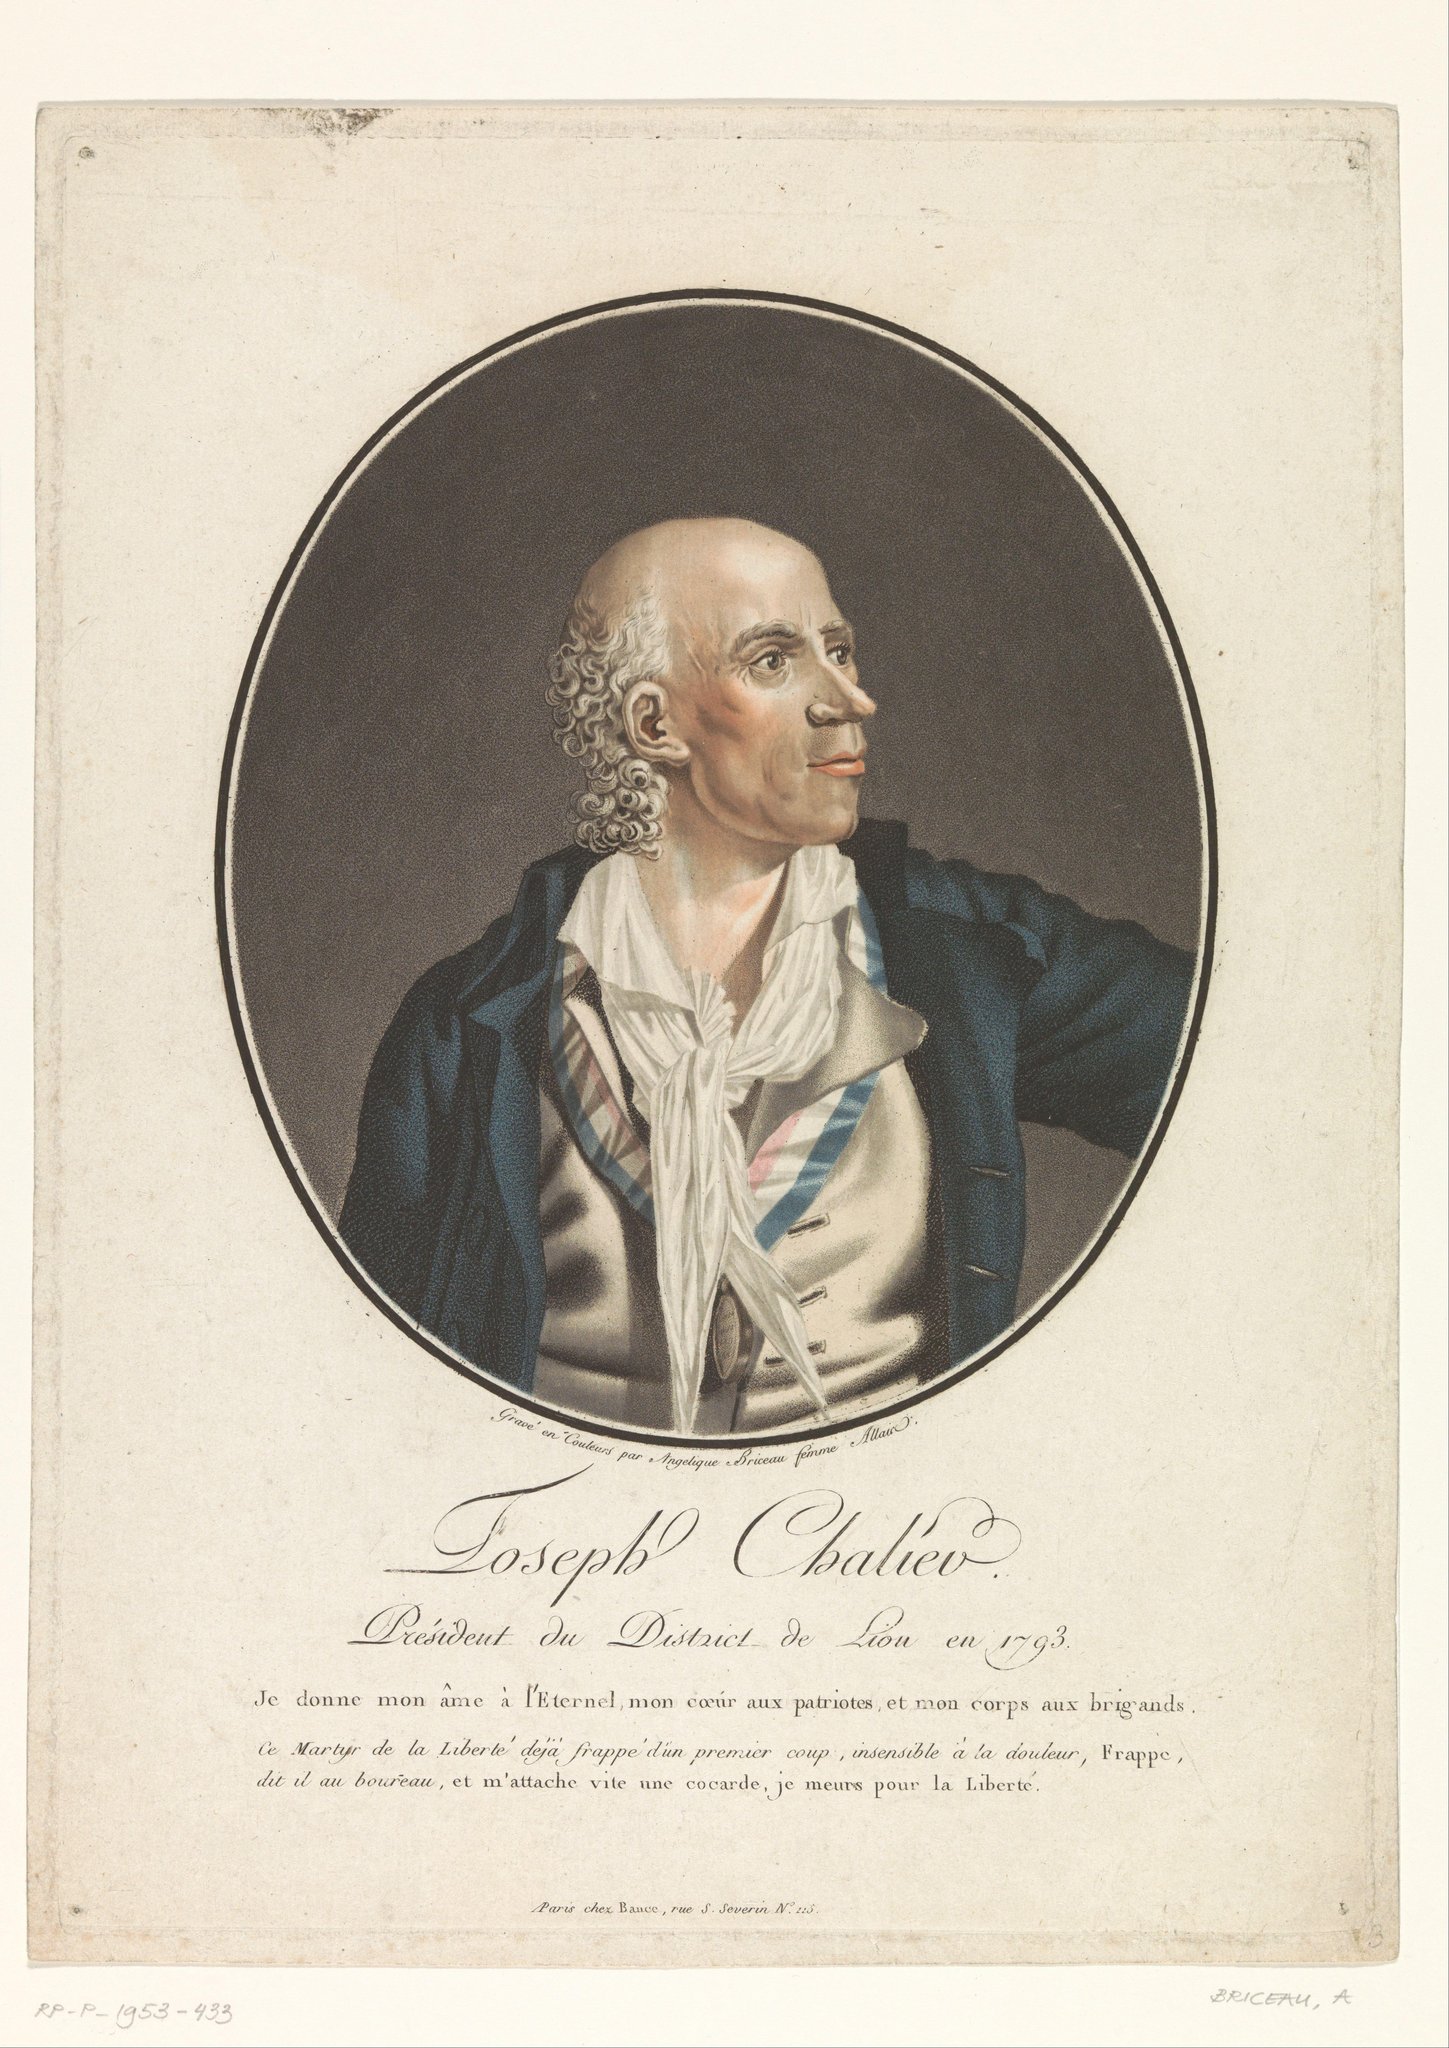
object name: print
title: Portret van Joseph Chalier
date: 1793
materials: paper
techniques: aquatint, engraving, etching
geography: paris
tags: politician, historical persons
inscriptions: collector's mark: Lugt 2228, collector's mark: Lugt 2760